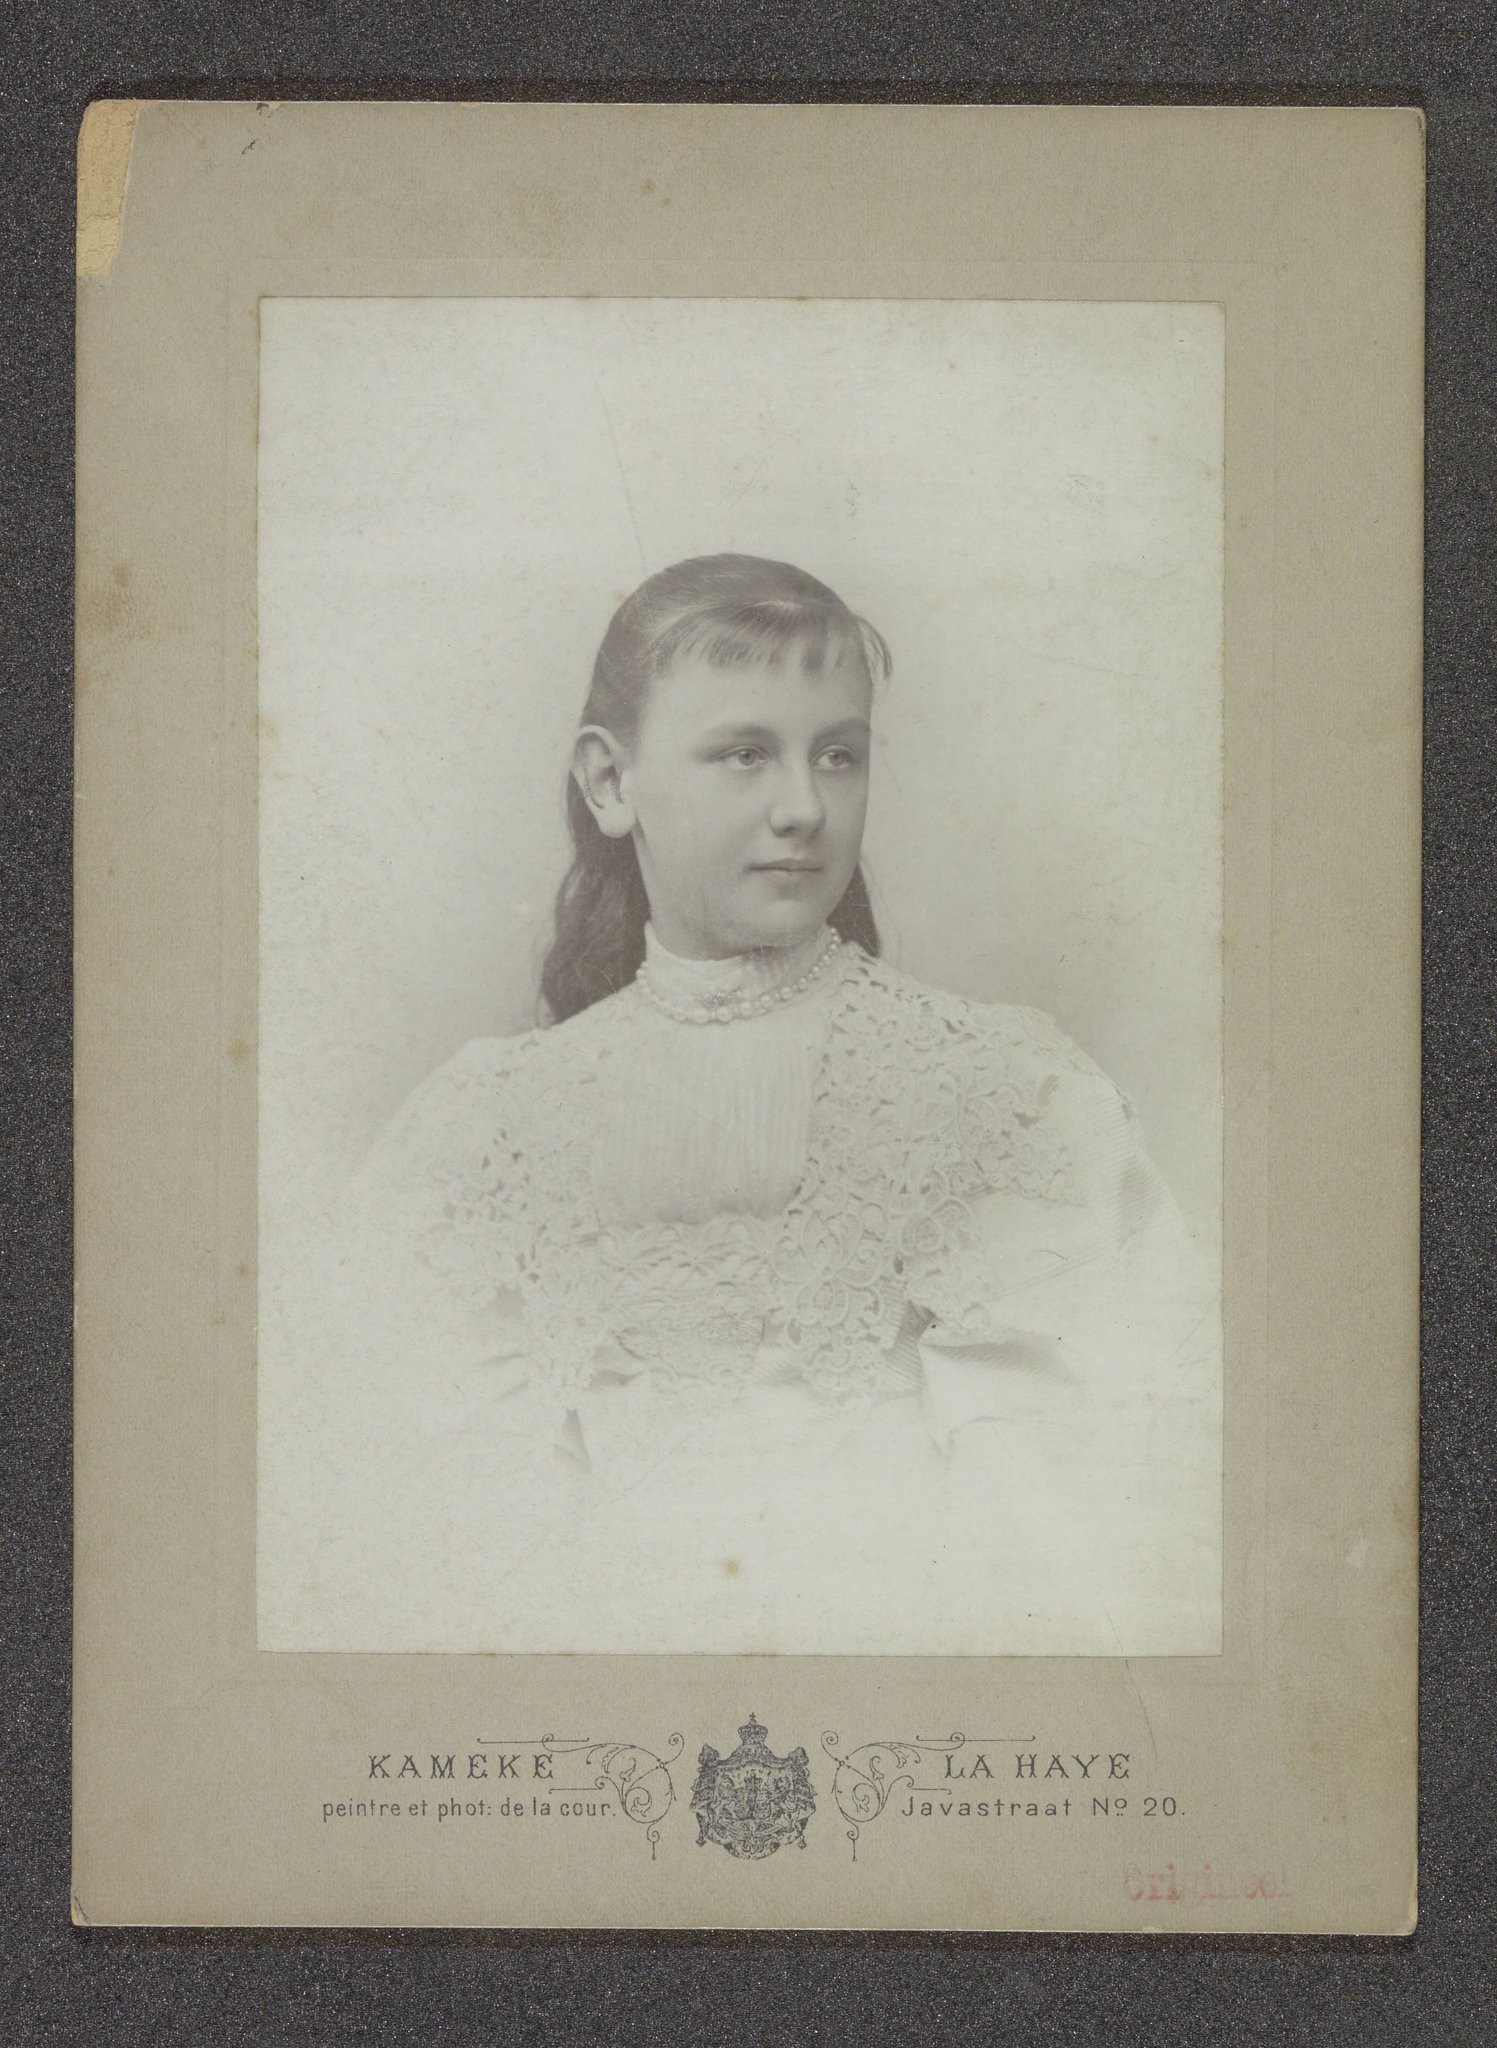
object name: photograph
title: Portret van jeugdige koningin Wilhelmina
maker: kameke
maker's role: painter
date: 1890-1896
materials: photographic support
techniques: albumen print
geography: the hague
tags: print maker, wilhelmina of the netherlands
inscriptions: name: ‘Kameke, peintre et phot: de la cour, La Haye Javastraat No 20’, date: ‘6-4-1894’